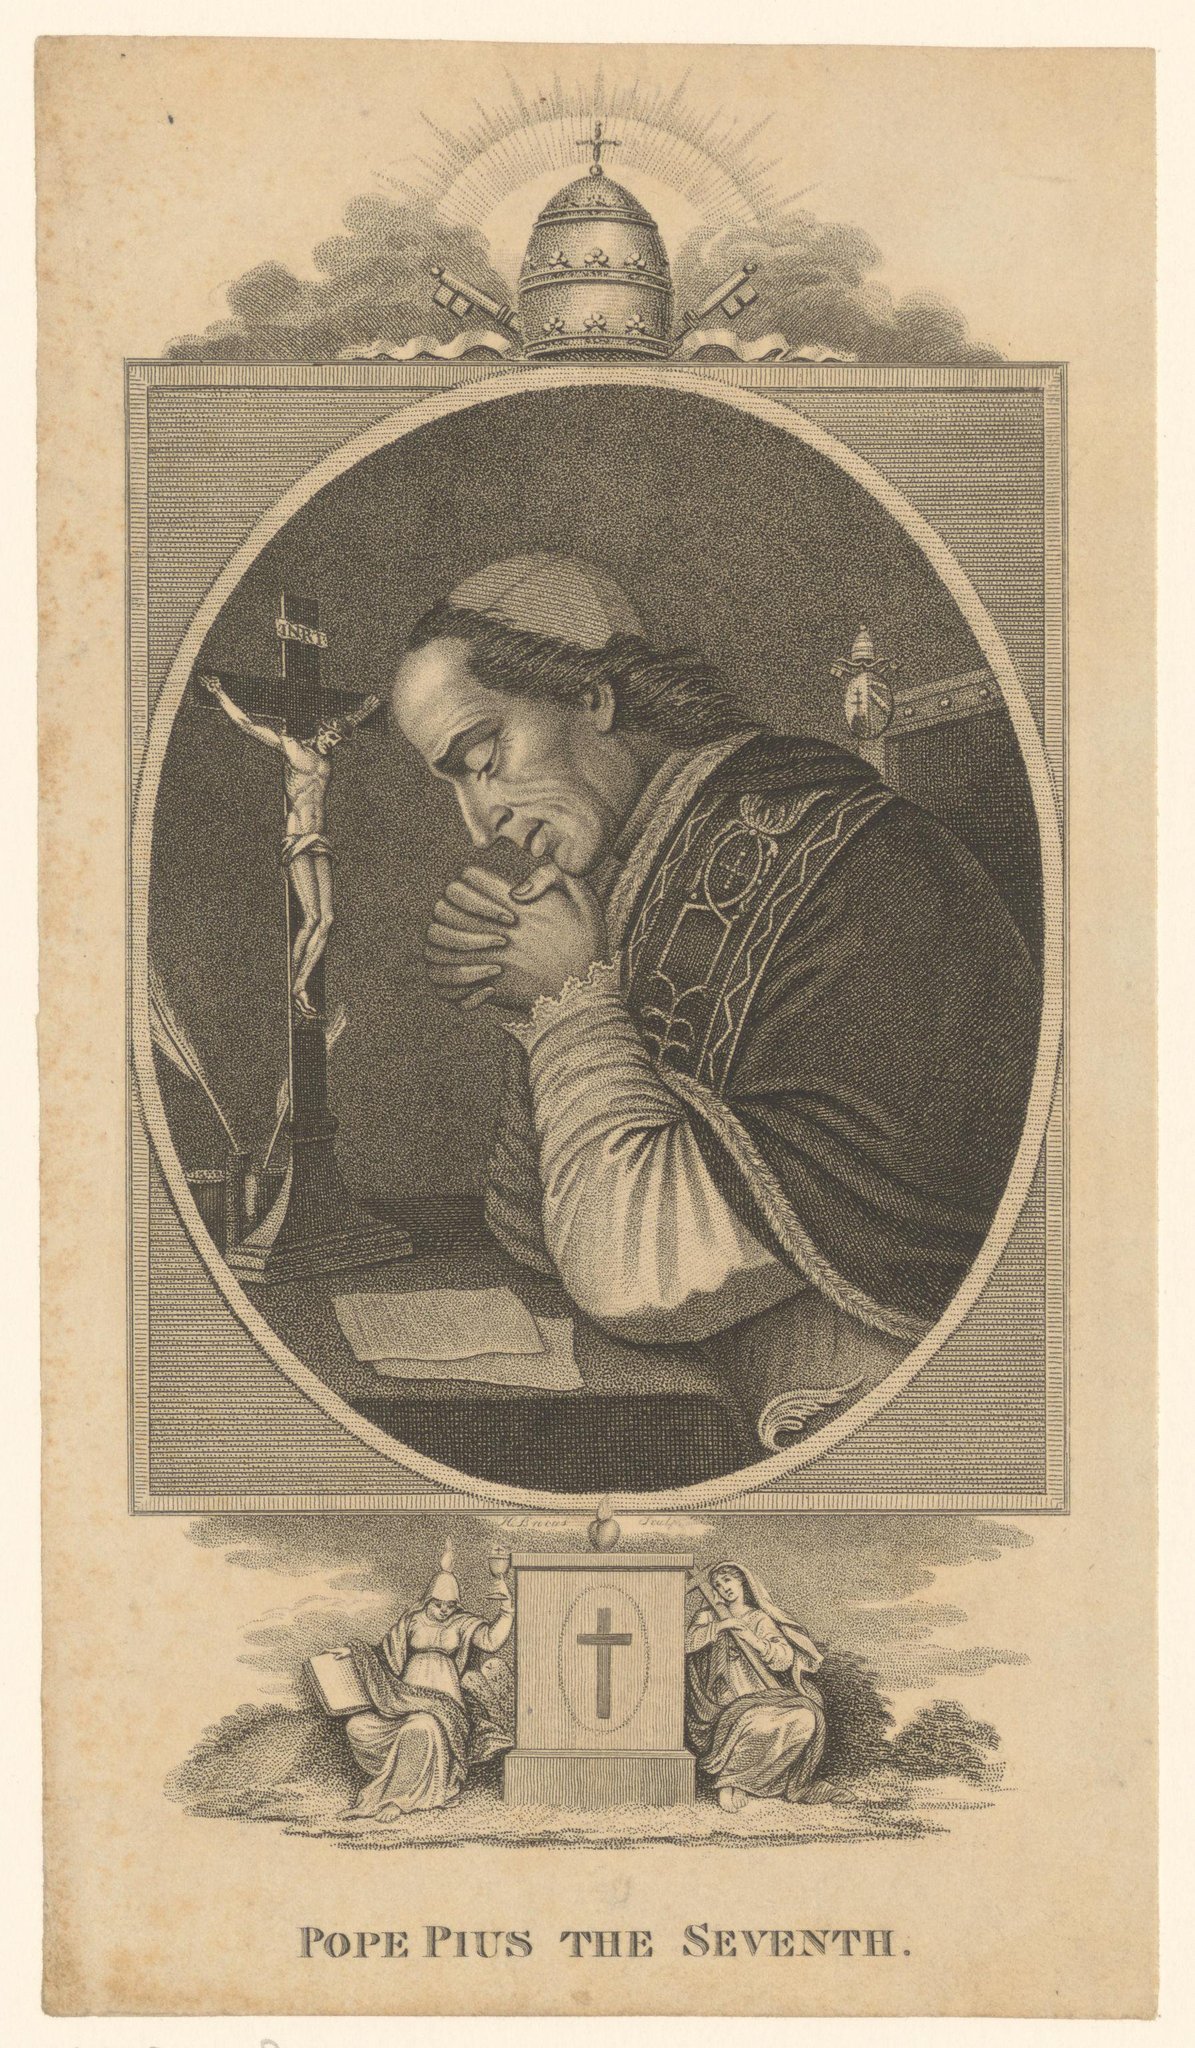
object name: print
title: Pope Pius the Seventh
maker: james henry brocas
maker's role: print maker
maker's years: 1766-1846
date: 1800-1846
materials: paper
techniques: etching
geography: ireland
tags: rome, pius vii, historical persons, pope, one person praying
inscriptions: collector's mark: Lugt 2228